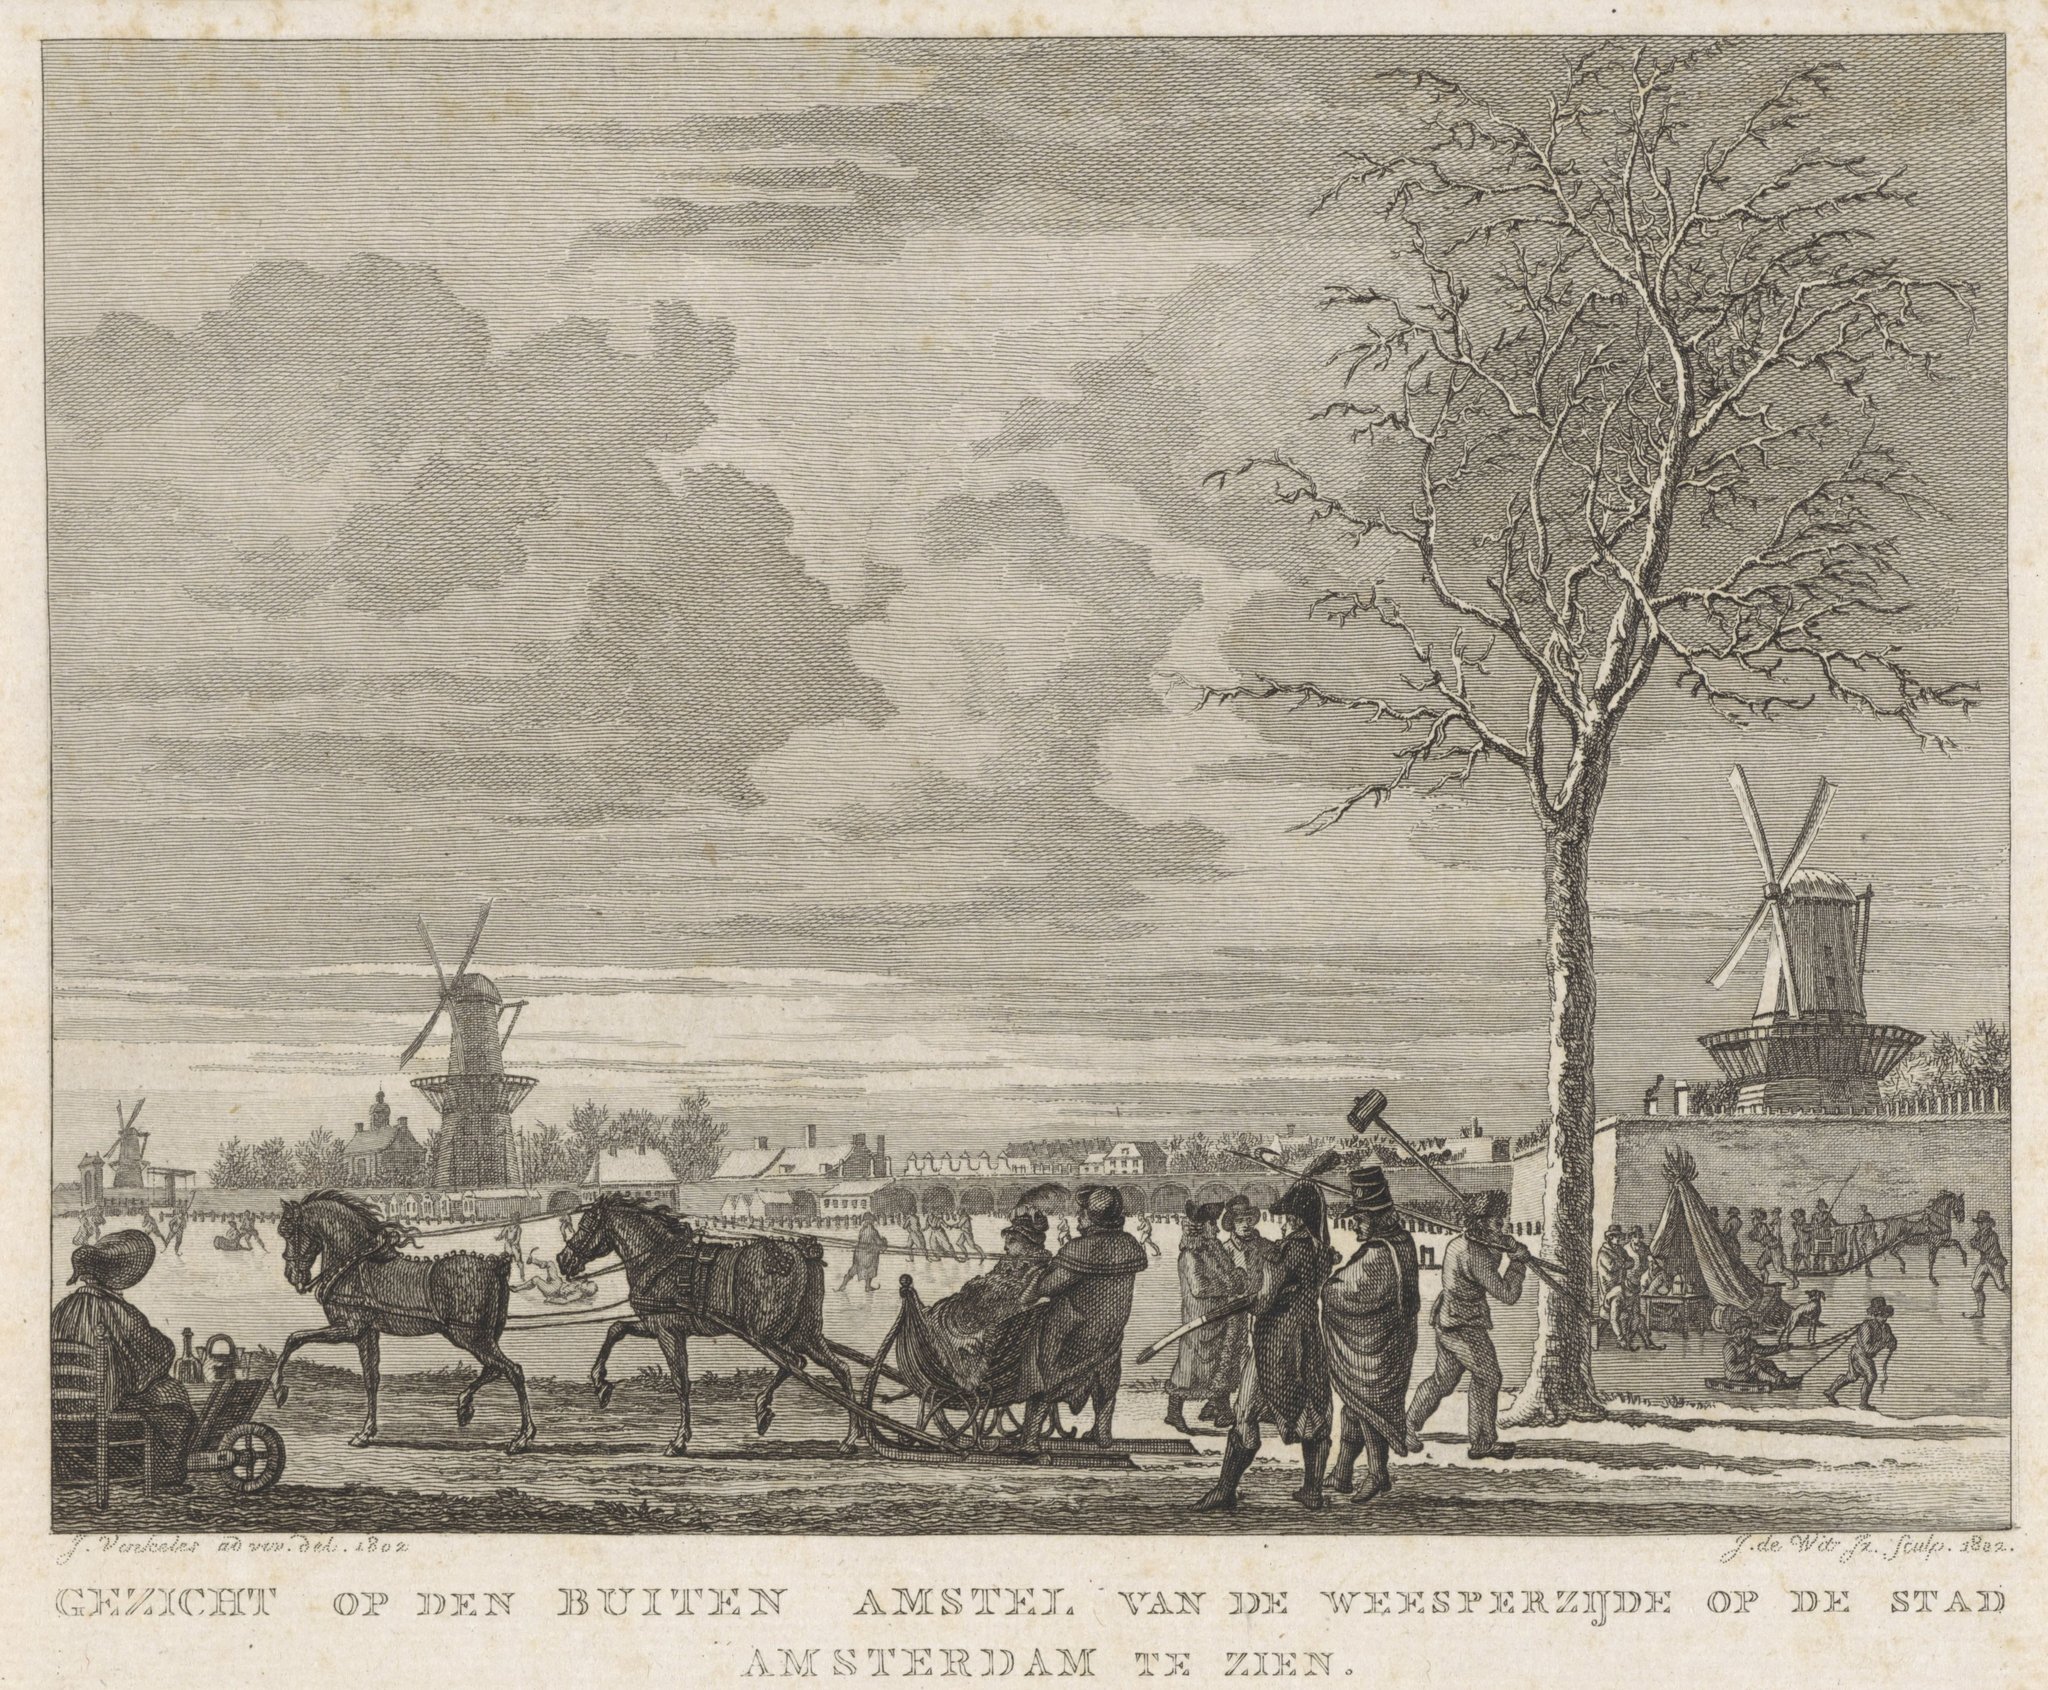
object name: print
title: IJspret aan de Amstel bij de Weesperzijde te Amsterdam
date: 1802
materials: paper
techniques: engraving, etching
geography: haarlem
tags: horse-sleigh, skates (winter sports), city-walls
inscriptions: collector's mark: Lugt 2228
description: Een paar wordt voortgetrokken door een door twee paarden getrokken slede, aan de Weesperzijde te Amsterdam. Op het bevroren water veel schaatsers en rechts een koek-en-zopietent.